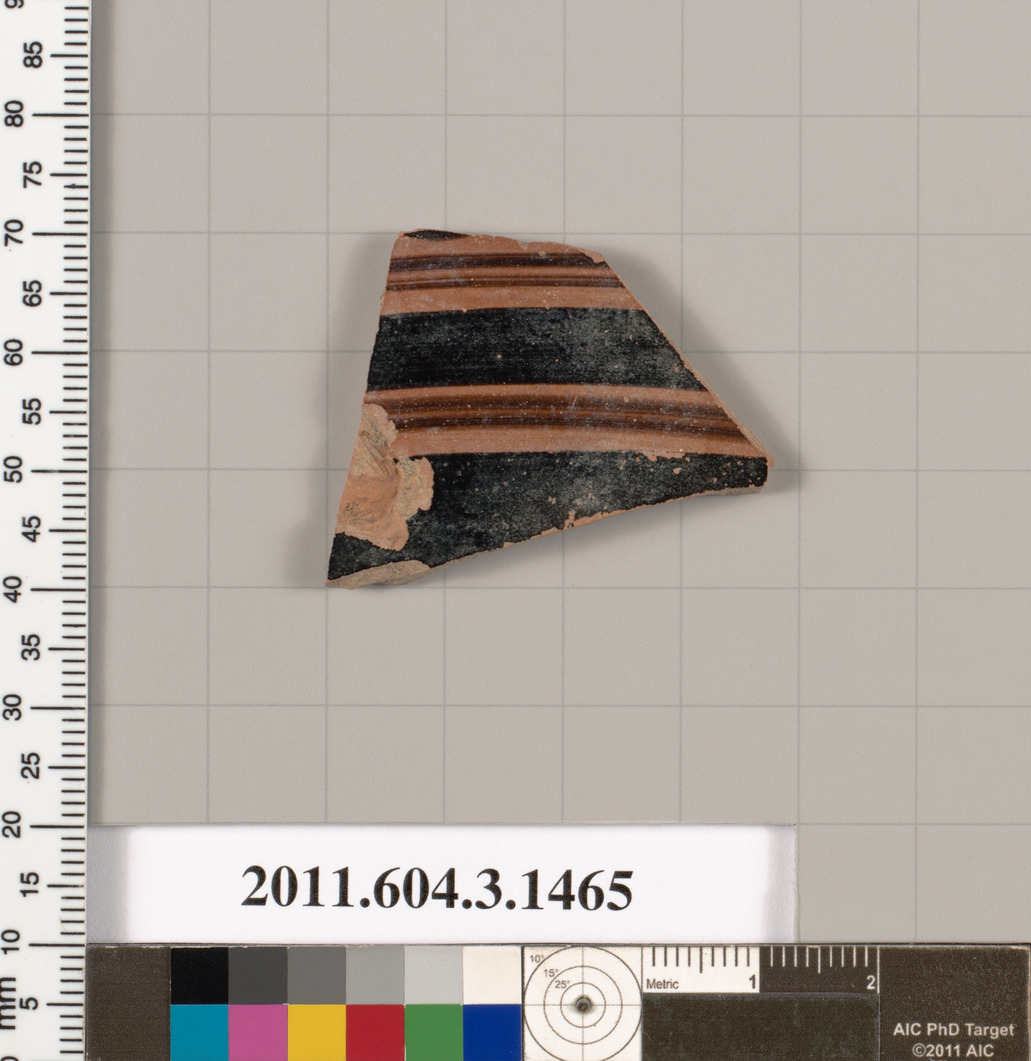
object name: skyphos fragment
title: Terracotta fragment of a skyphos (deep drinking cup)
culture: greek, attic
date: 600-401 BCE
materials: terracotta